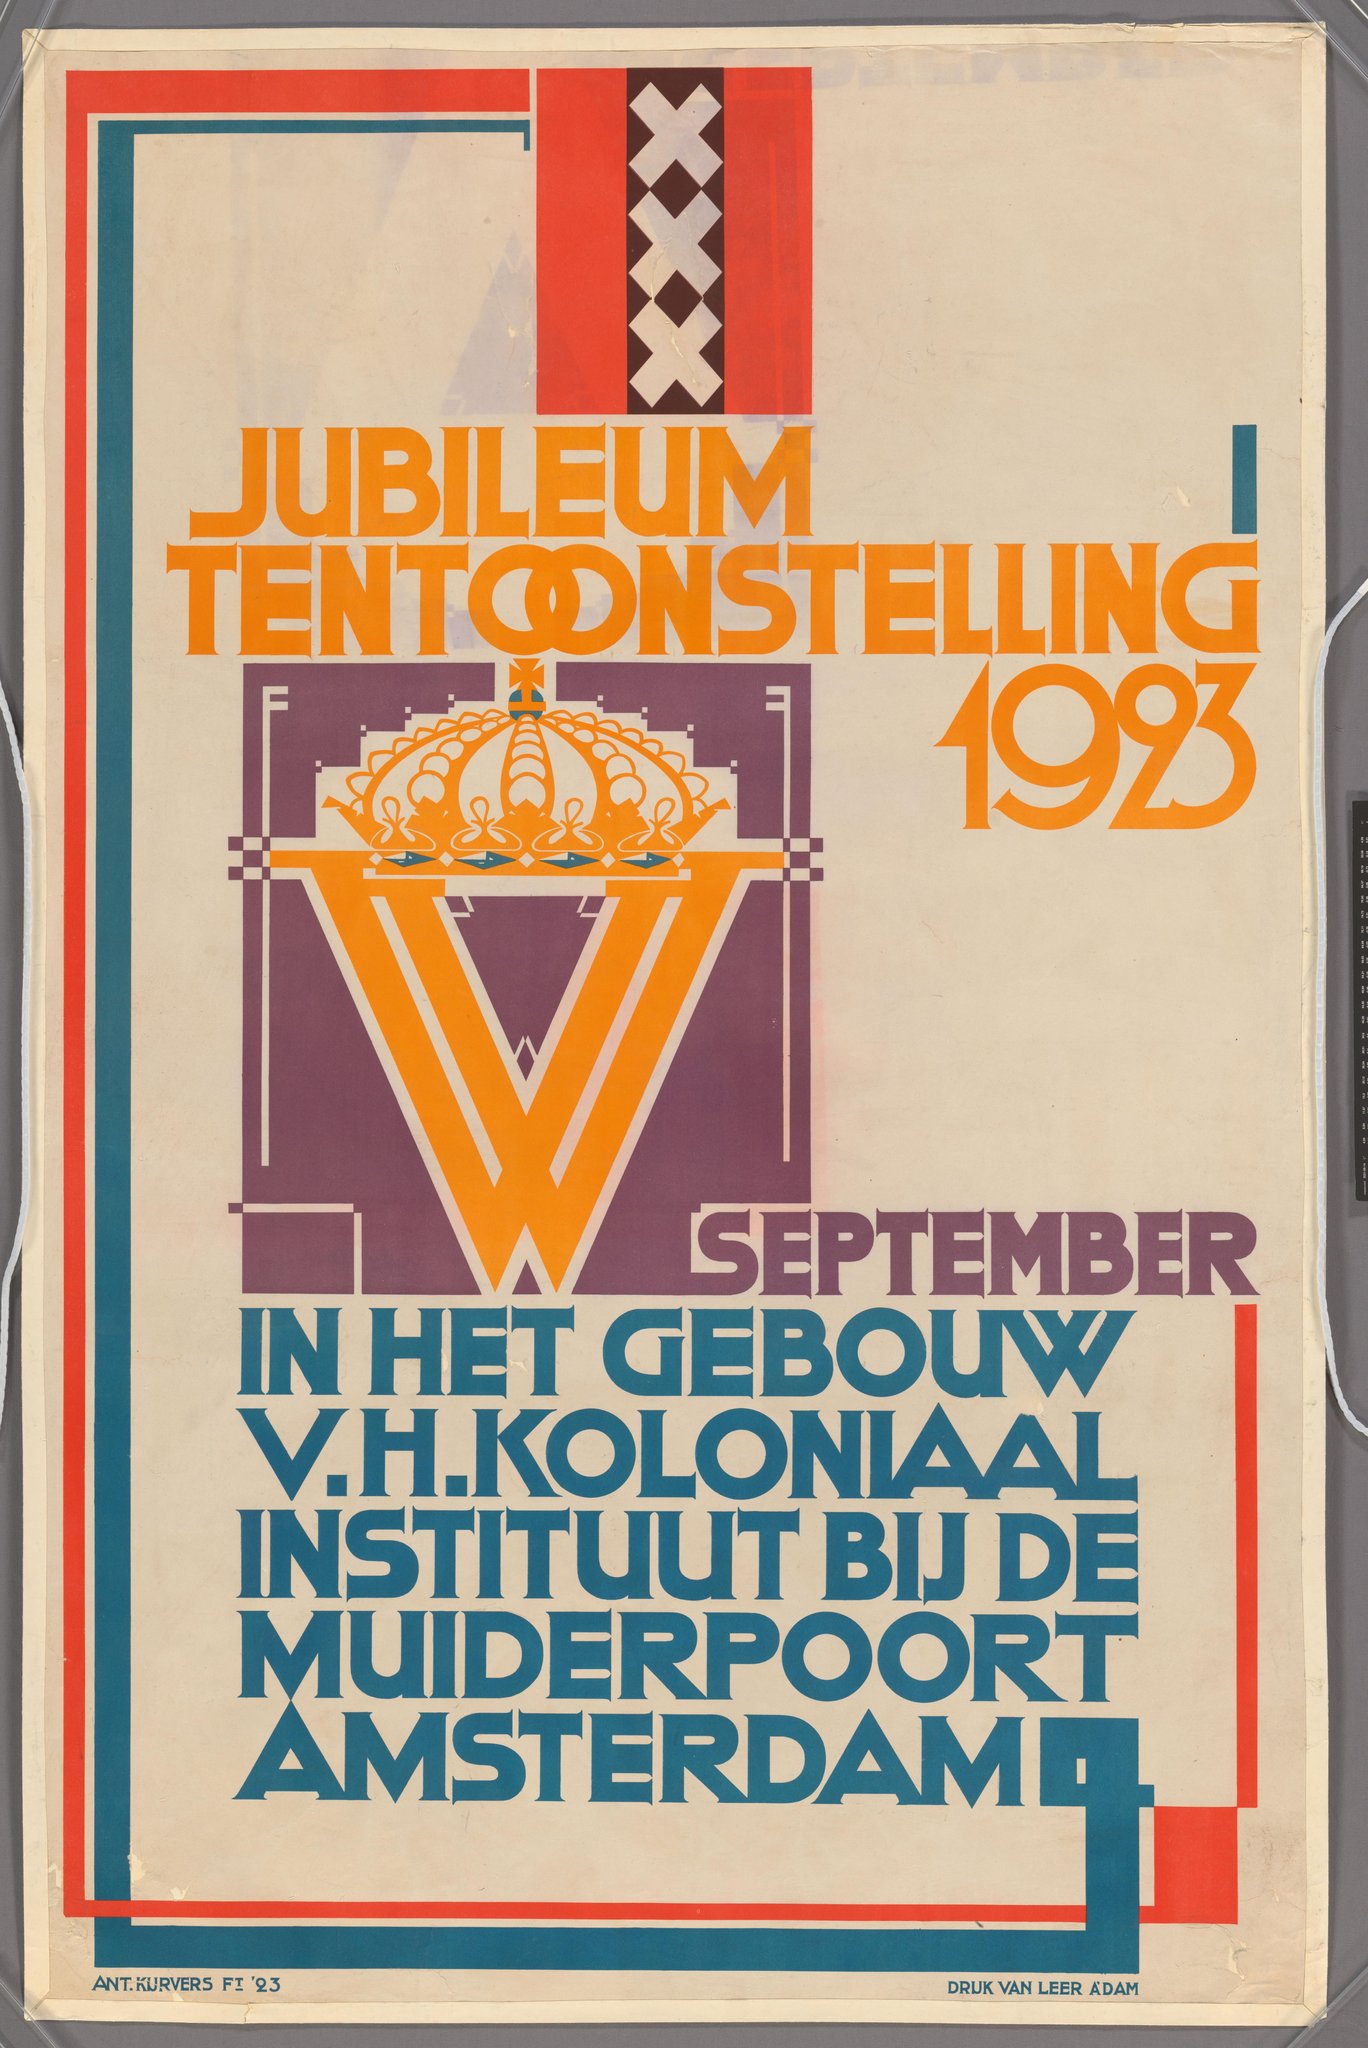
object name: print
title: Jubileum tentoonstelling 1923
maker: anton kurvers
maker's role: designer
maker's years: 1889-1940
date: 1923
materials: paper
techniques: lithograph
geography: amsterdam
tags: the hague, print maker, wilhelmina of the netherlands, crown (symbol of sovereignty)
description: Affiche ter promotie van een tentoonstelling ter ere van het 25-jarig jubileum van koningin Wilhelmina in het Koloniaal Instituut in Amsterdam in 1923. Dubbele V met een kroon en het wapen van Amsterdam.